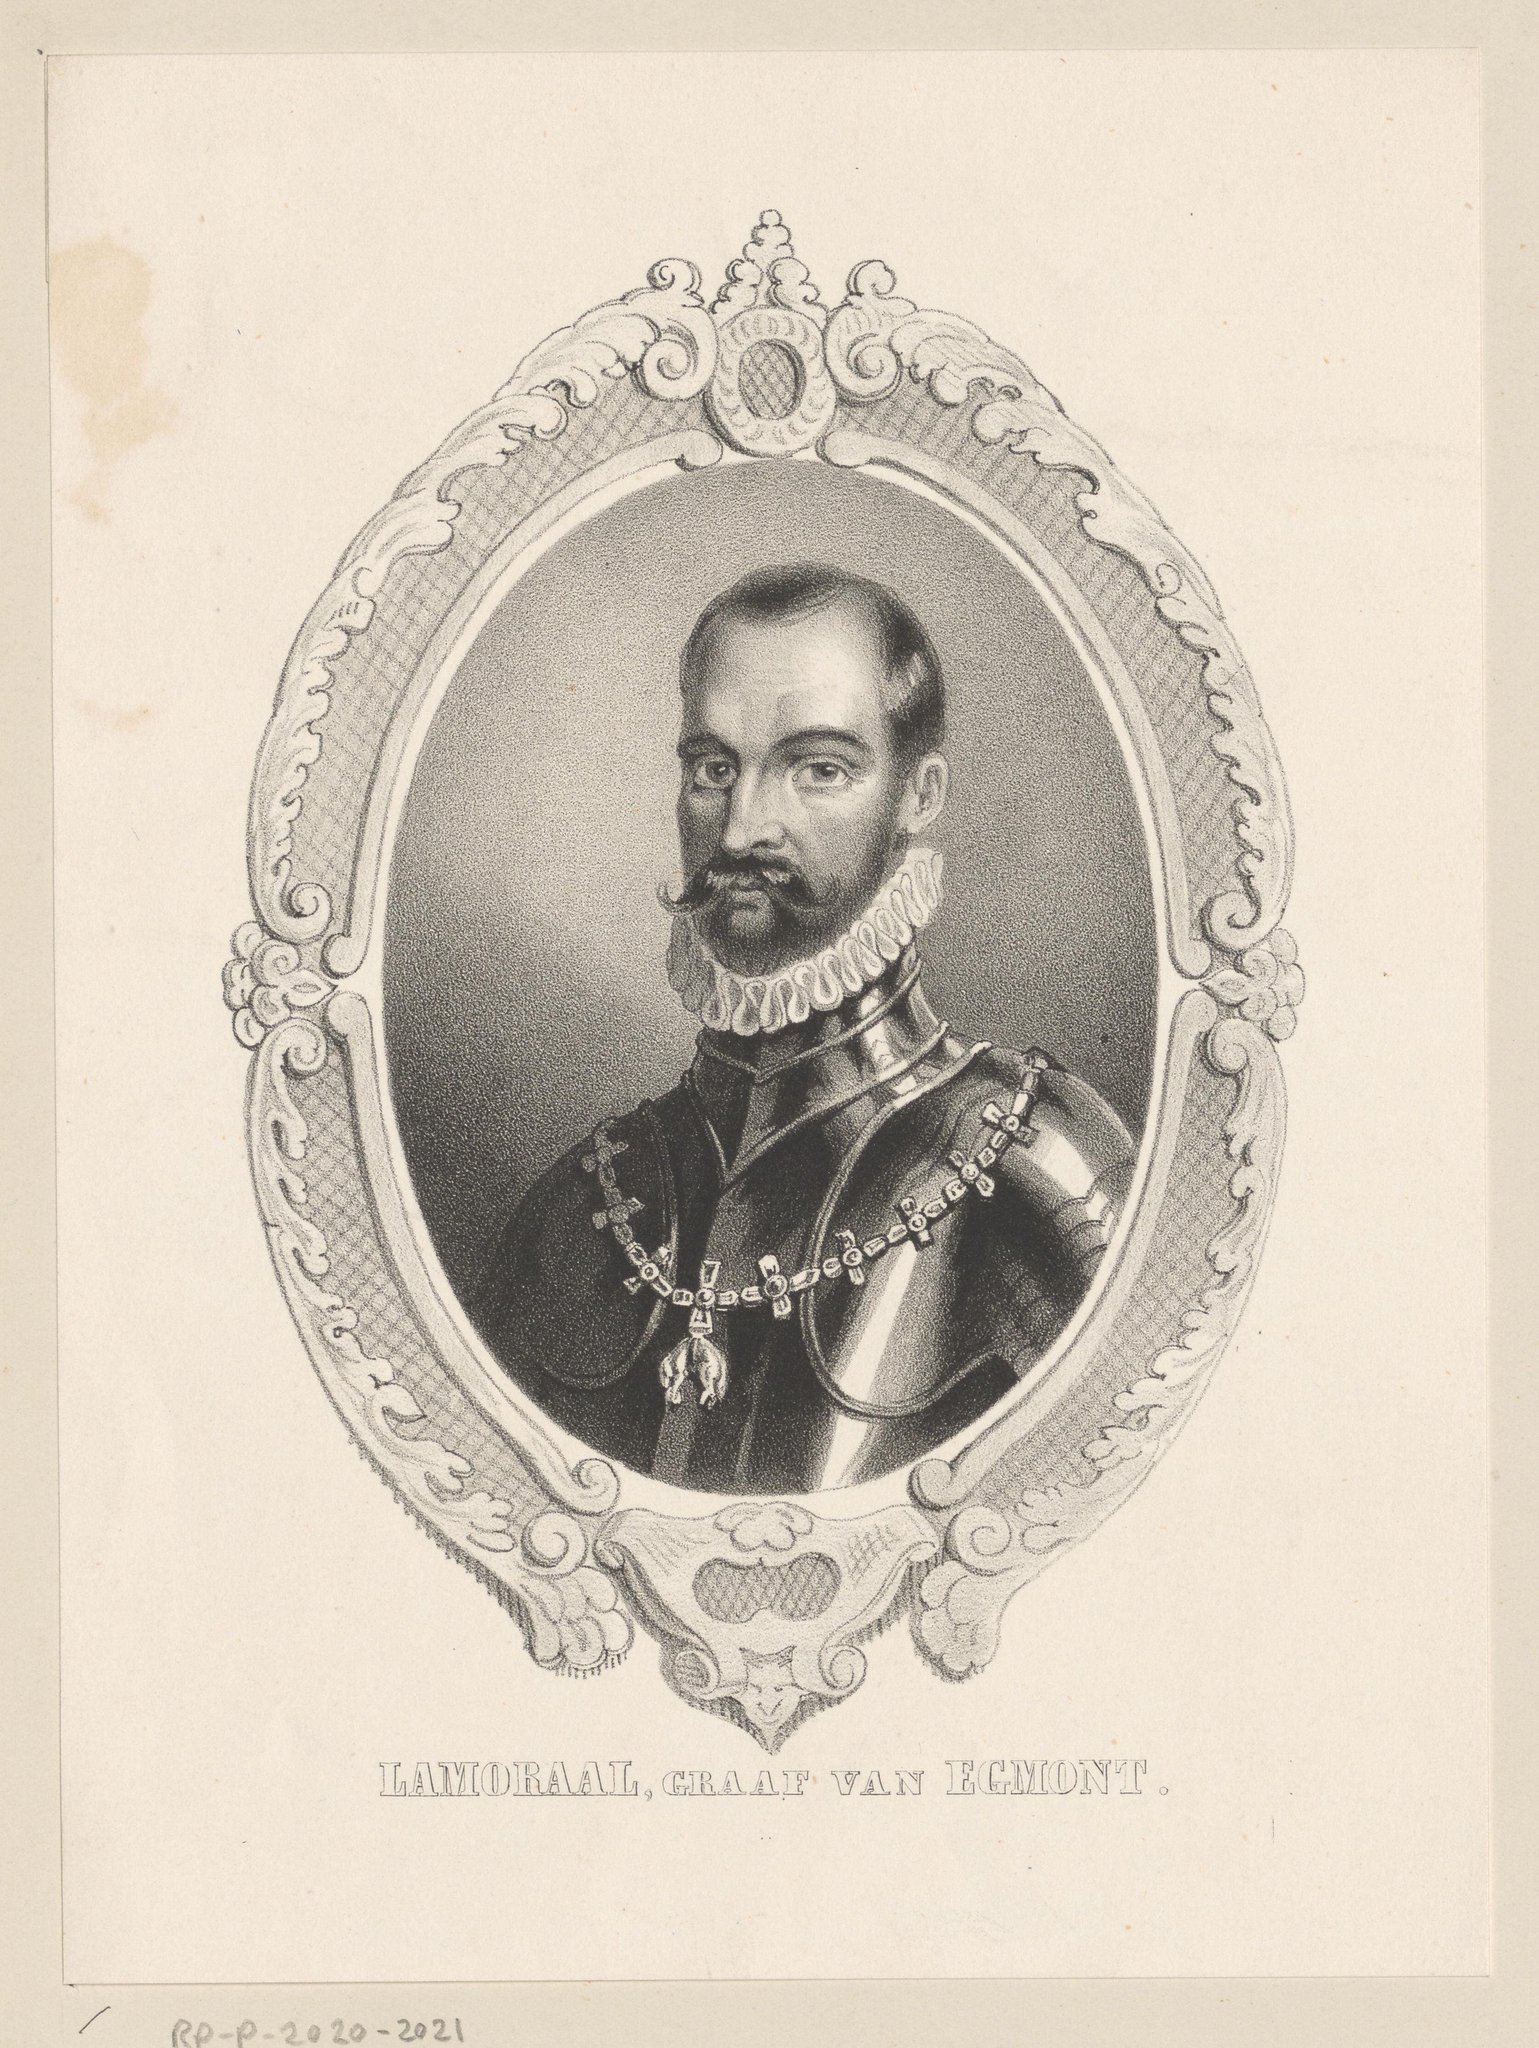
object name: print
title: Portret van Lamoraal van Egmond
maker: Anonymous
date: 1820-1900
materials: paper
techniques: lithograph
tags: brussels, earl, historical persons, knighthood order of the golden fleece